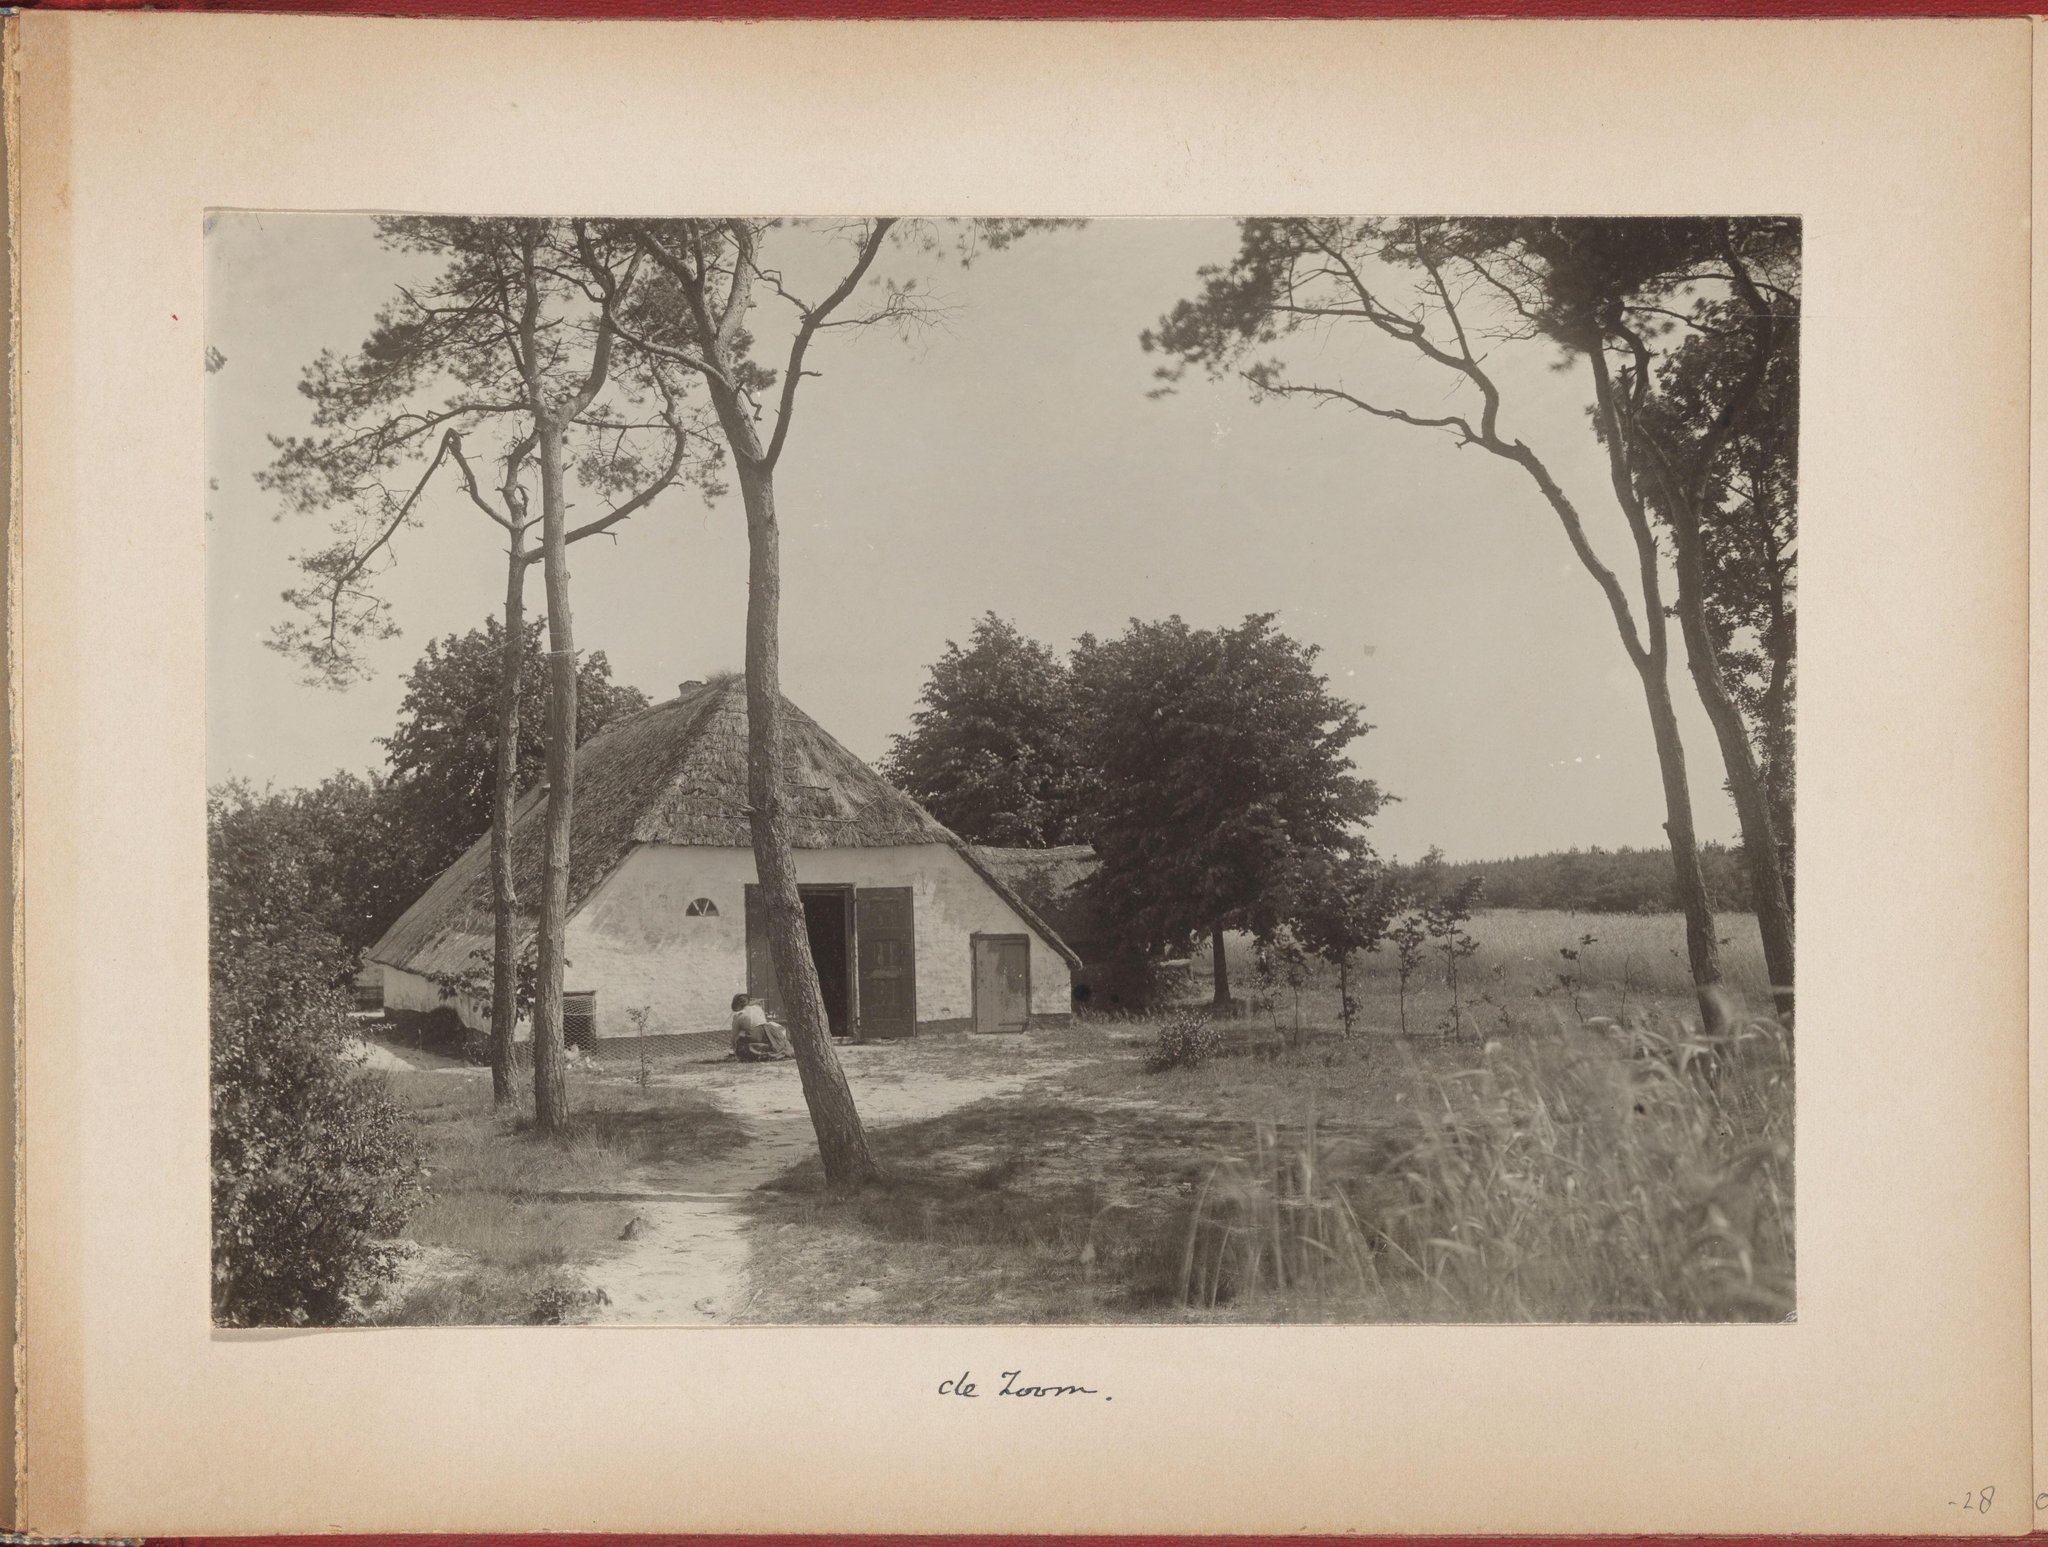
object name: photograph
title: Landschap met een boerderij op de Zoom bij Nunspeet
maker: gerard aalbersberg (us)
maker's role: amateurfotograaf, arts, chirurg, gynaecoloog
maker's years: 1870-1934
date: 1900-1906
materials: paper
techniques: gelatin silver print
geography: nunspeet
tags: nunspeet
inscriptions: title: ‘de Zoom’